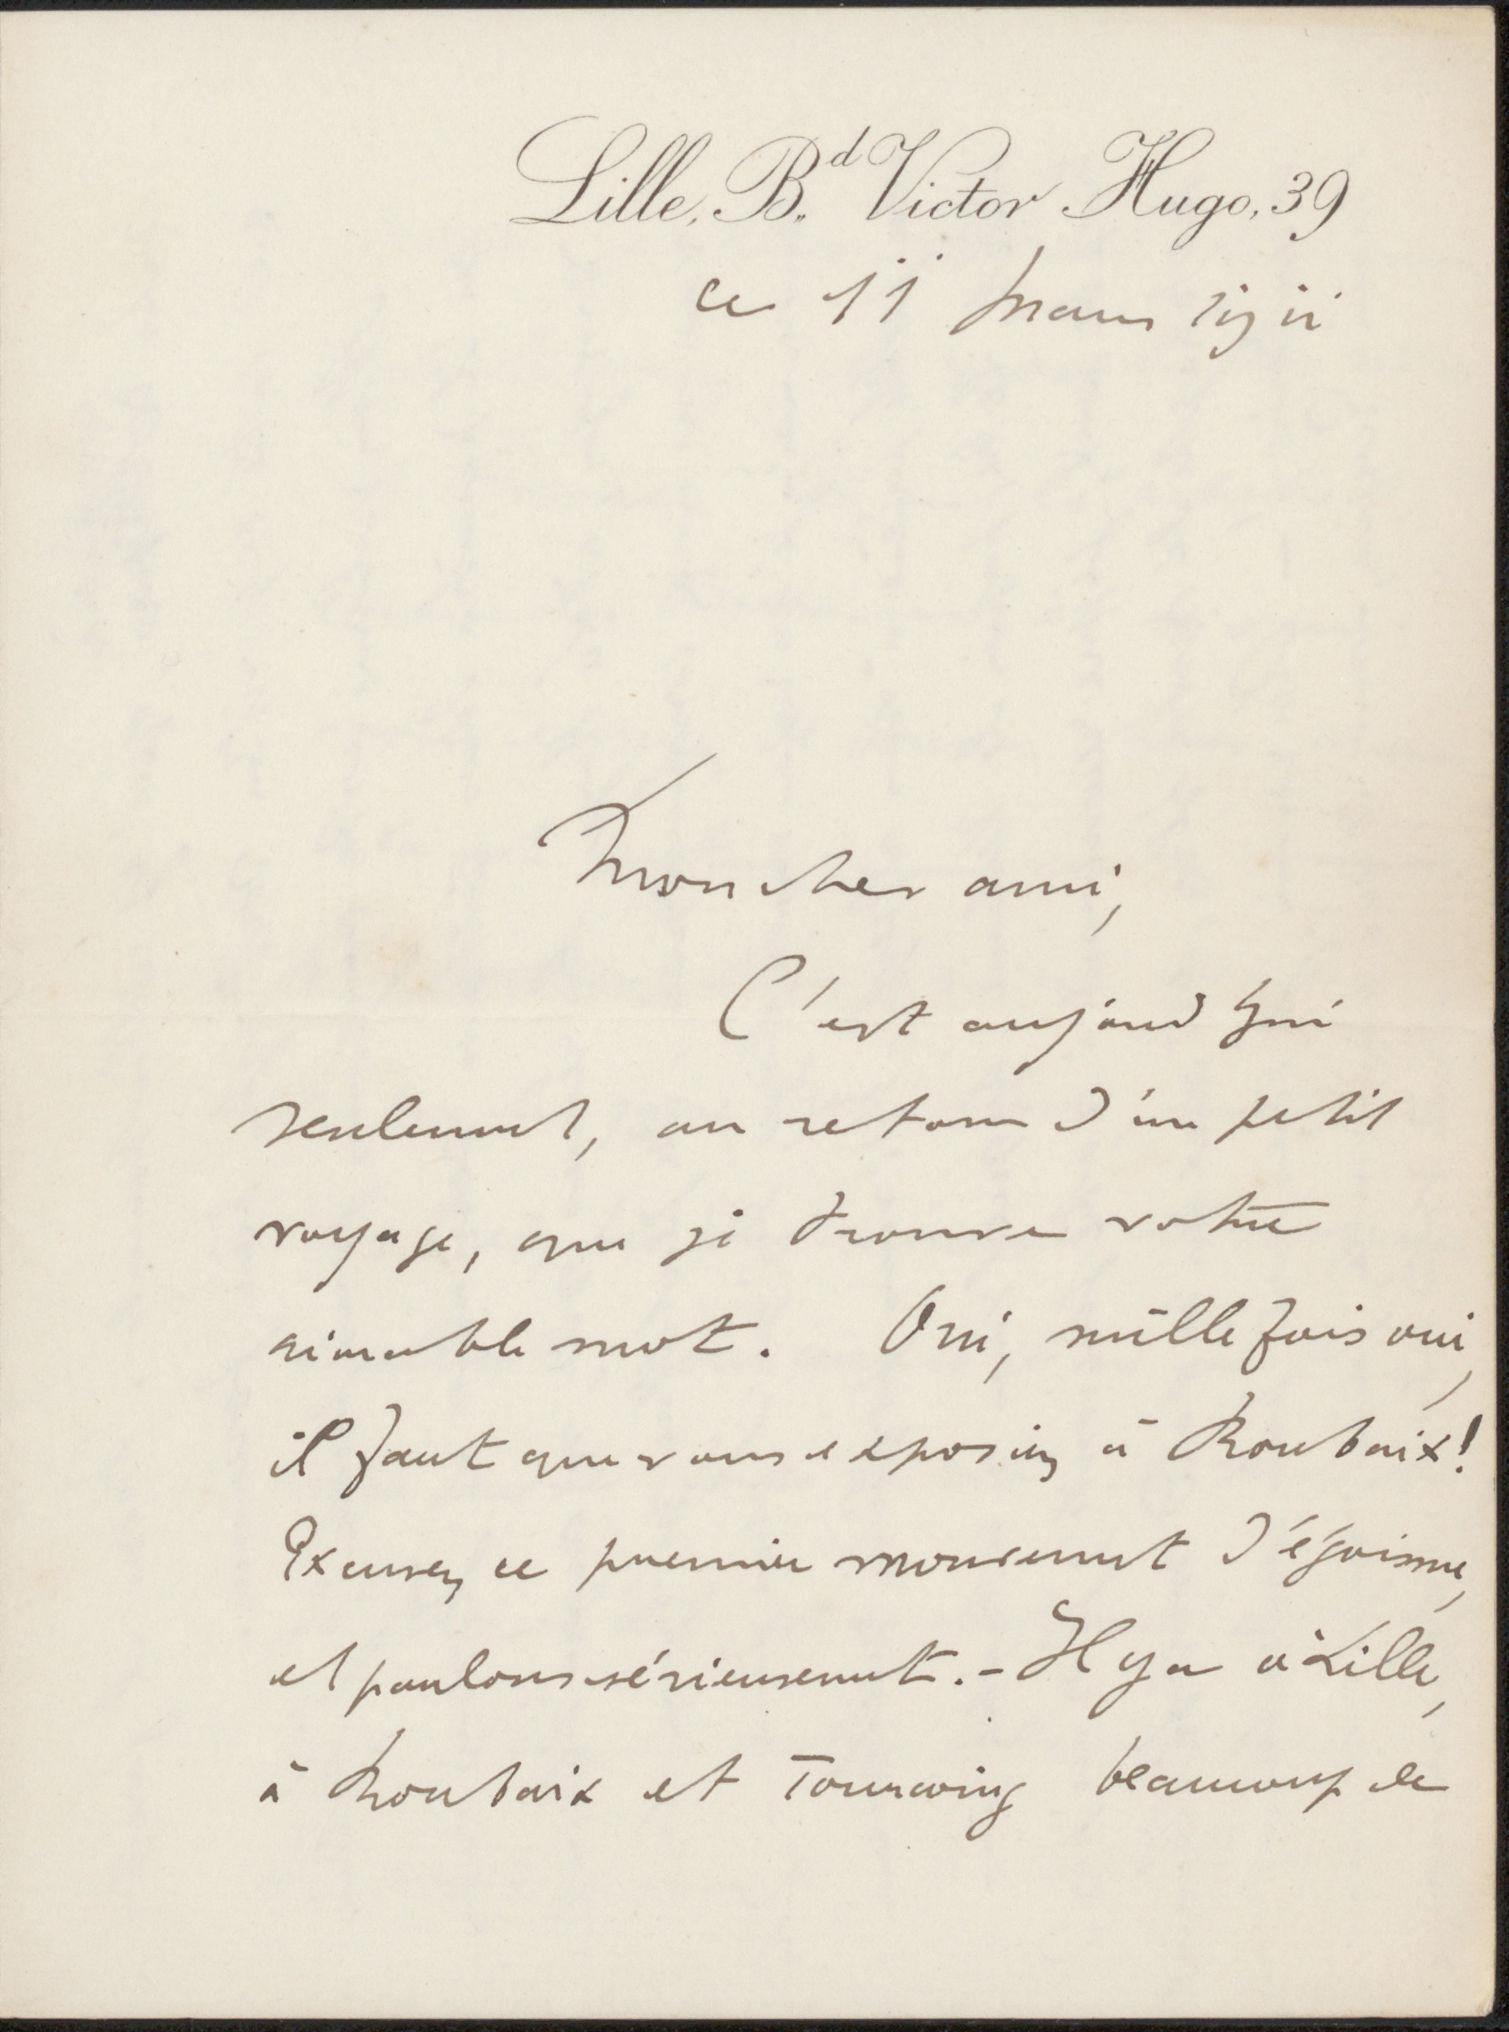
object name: letter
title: Brief aan Philip Zilcken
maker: georges a. tournoux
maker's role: professor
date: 1911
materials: ink, paper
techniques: pen, printing, writing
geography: lille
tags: paris, paul verlaine, the hague, painter, philip zilcken, exhibition ~ art, lille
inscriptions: watermark, collector's mark: ‘RPK’, address: ‘Lille, Bd. Victor Hugo, 39’